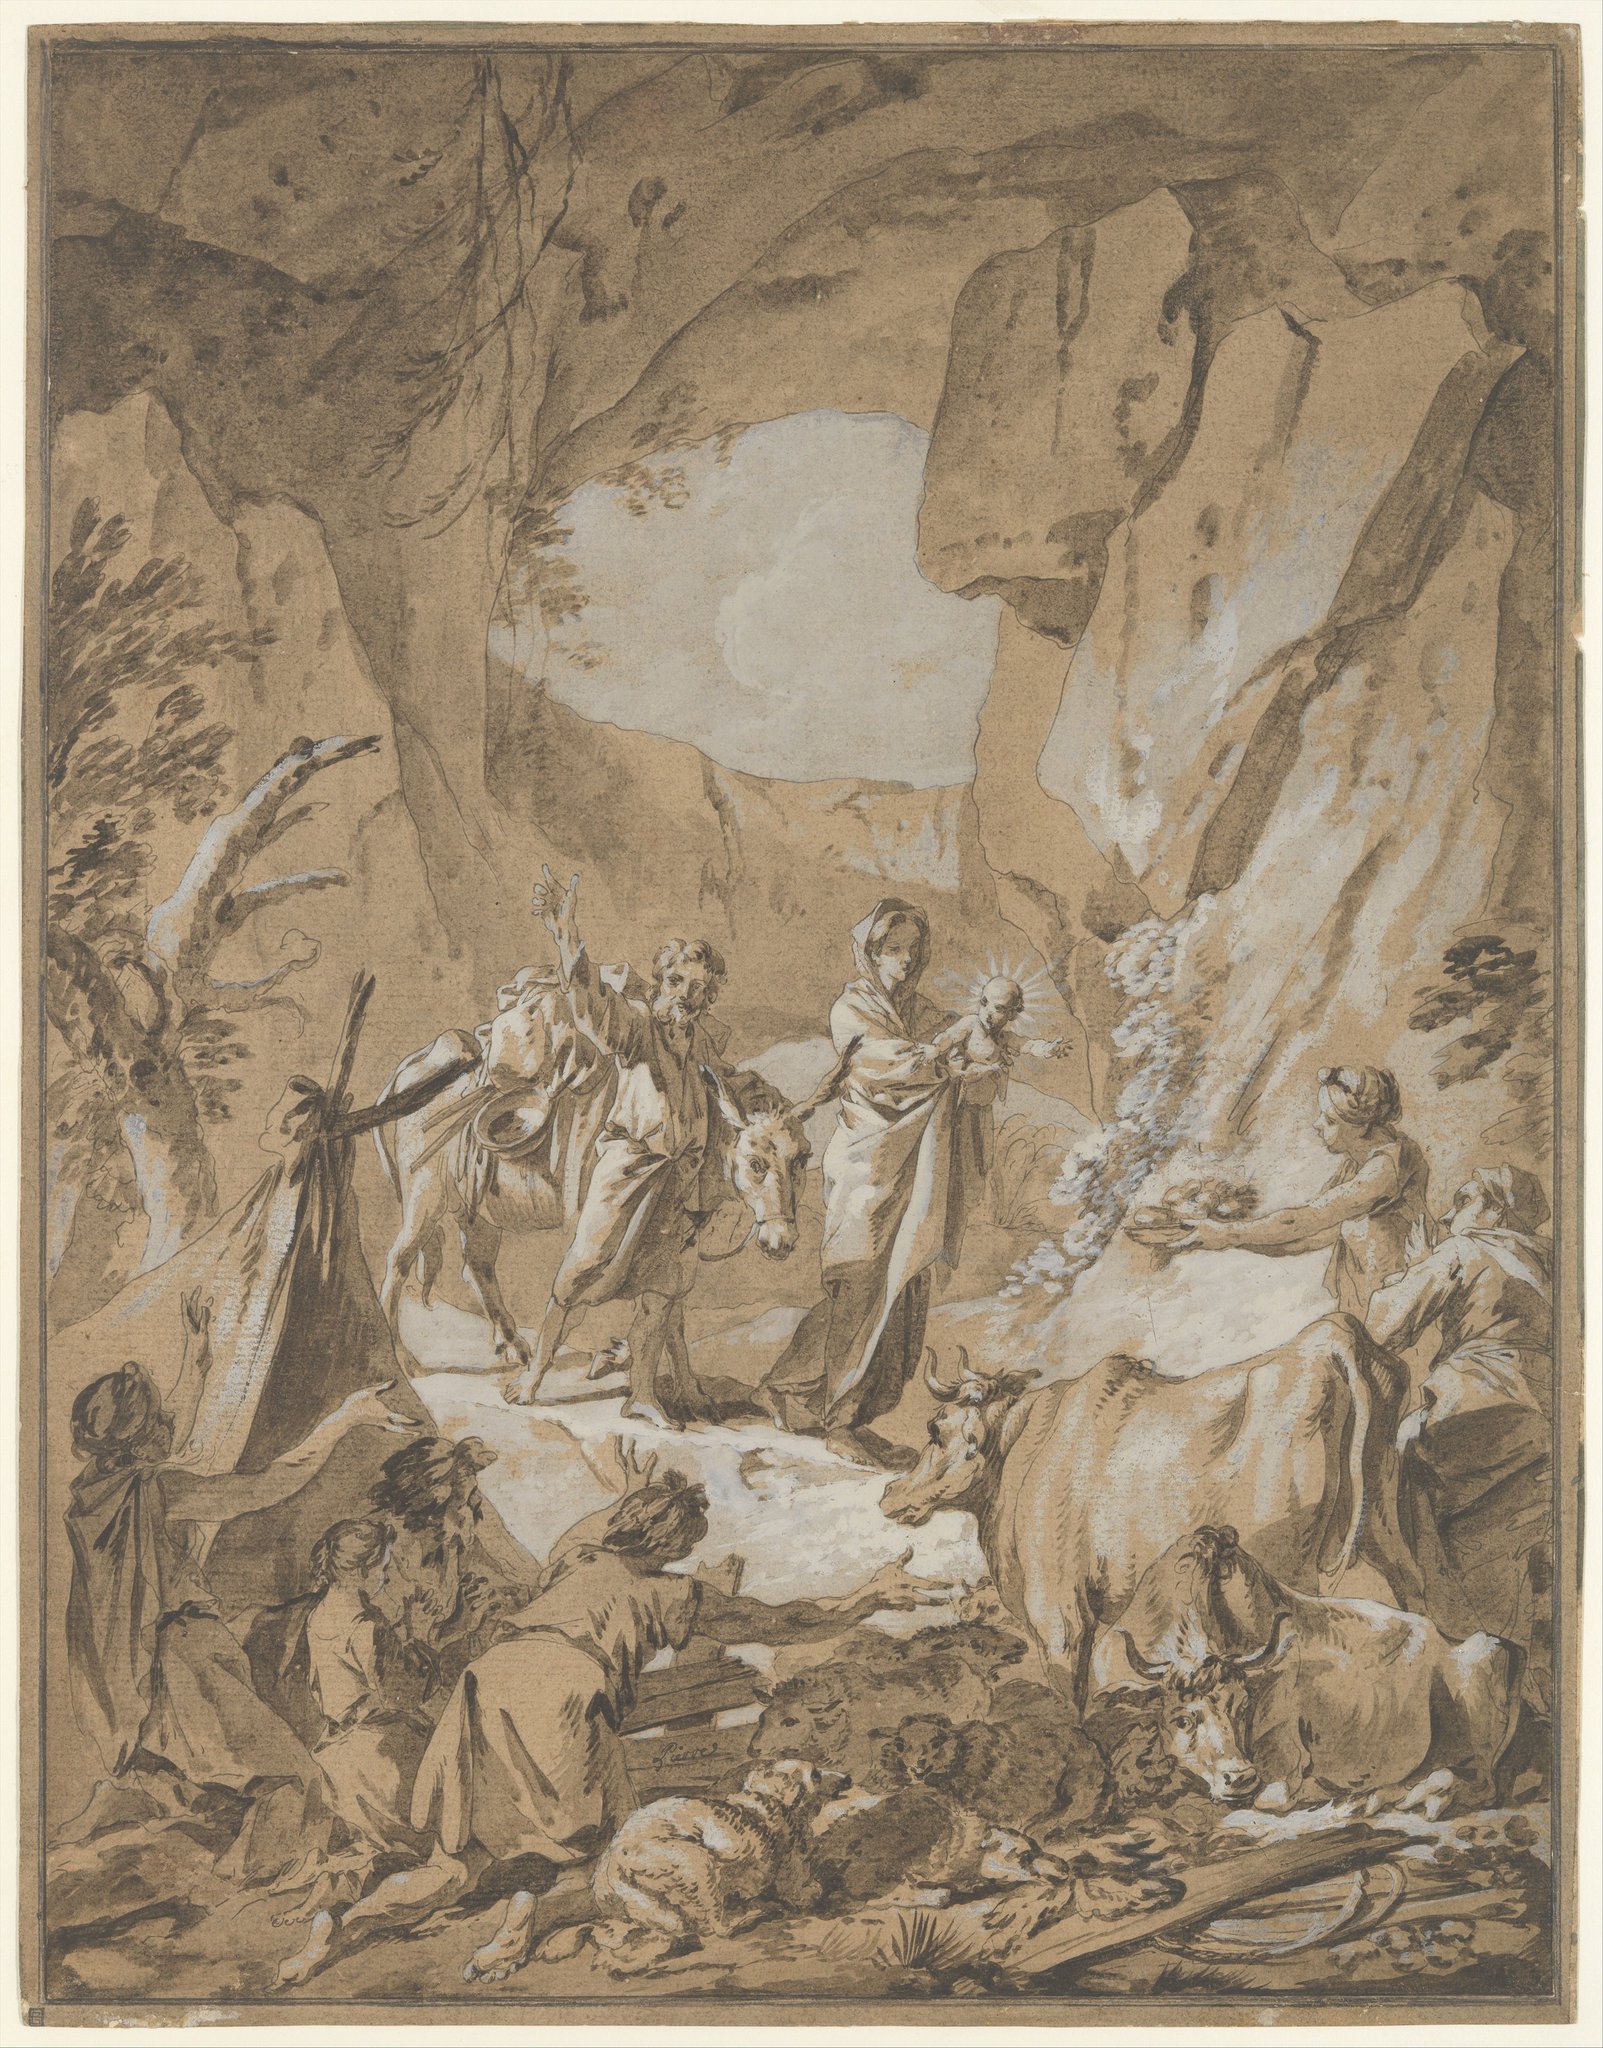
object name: drawing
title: The Flight into Egypt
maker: jean-baptiste marie pierre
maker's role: artist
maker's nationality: french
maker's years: 1714-1789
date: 1701-1800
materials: ink, paper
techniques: brush, heightening, pen, wash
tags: men,cows,horses,madonna and child